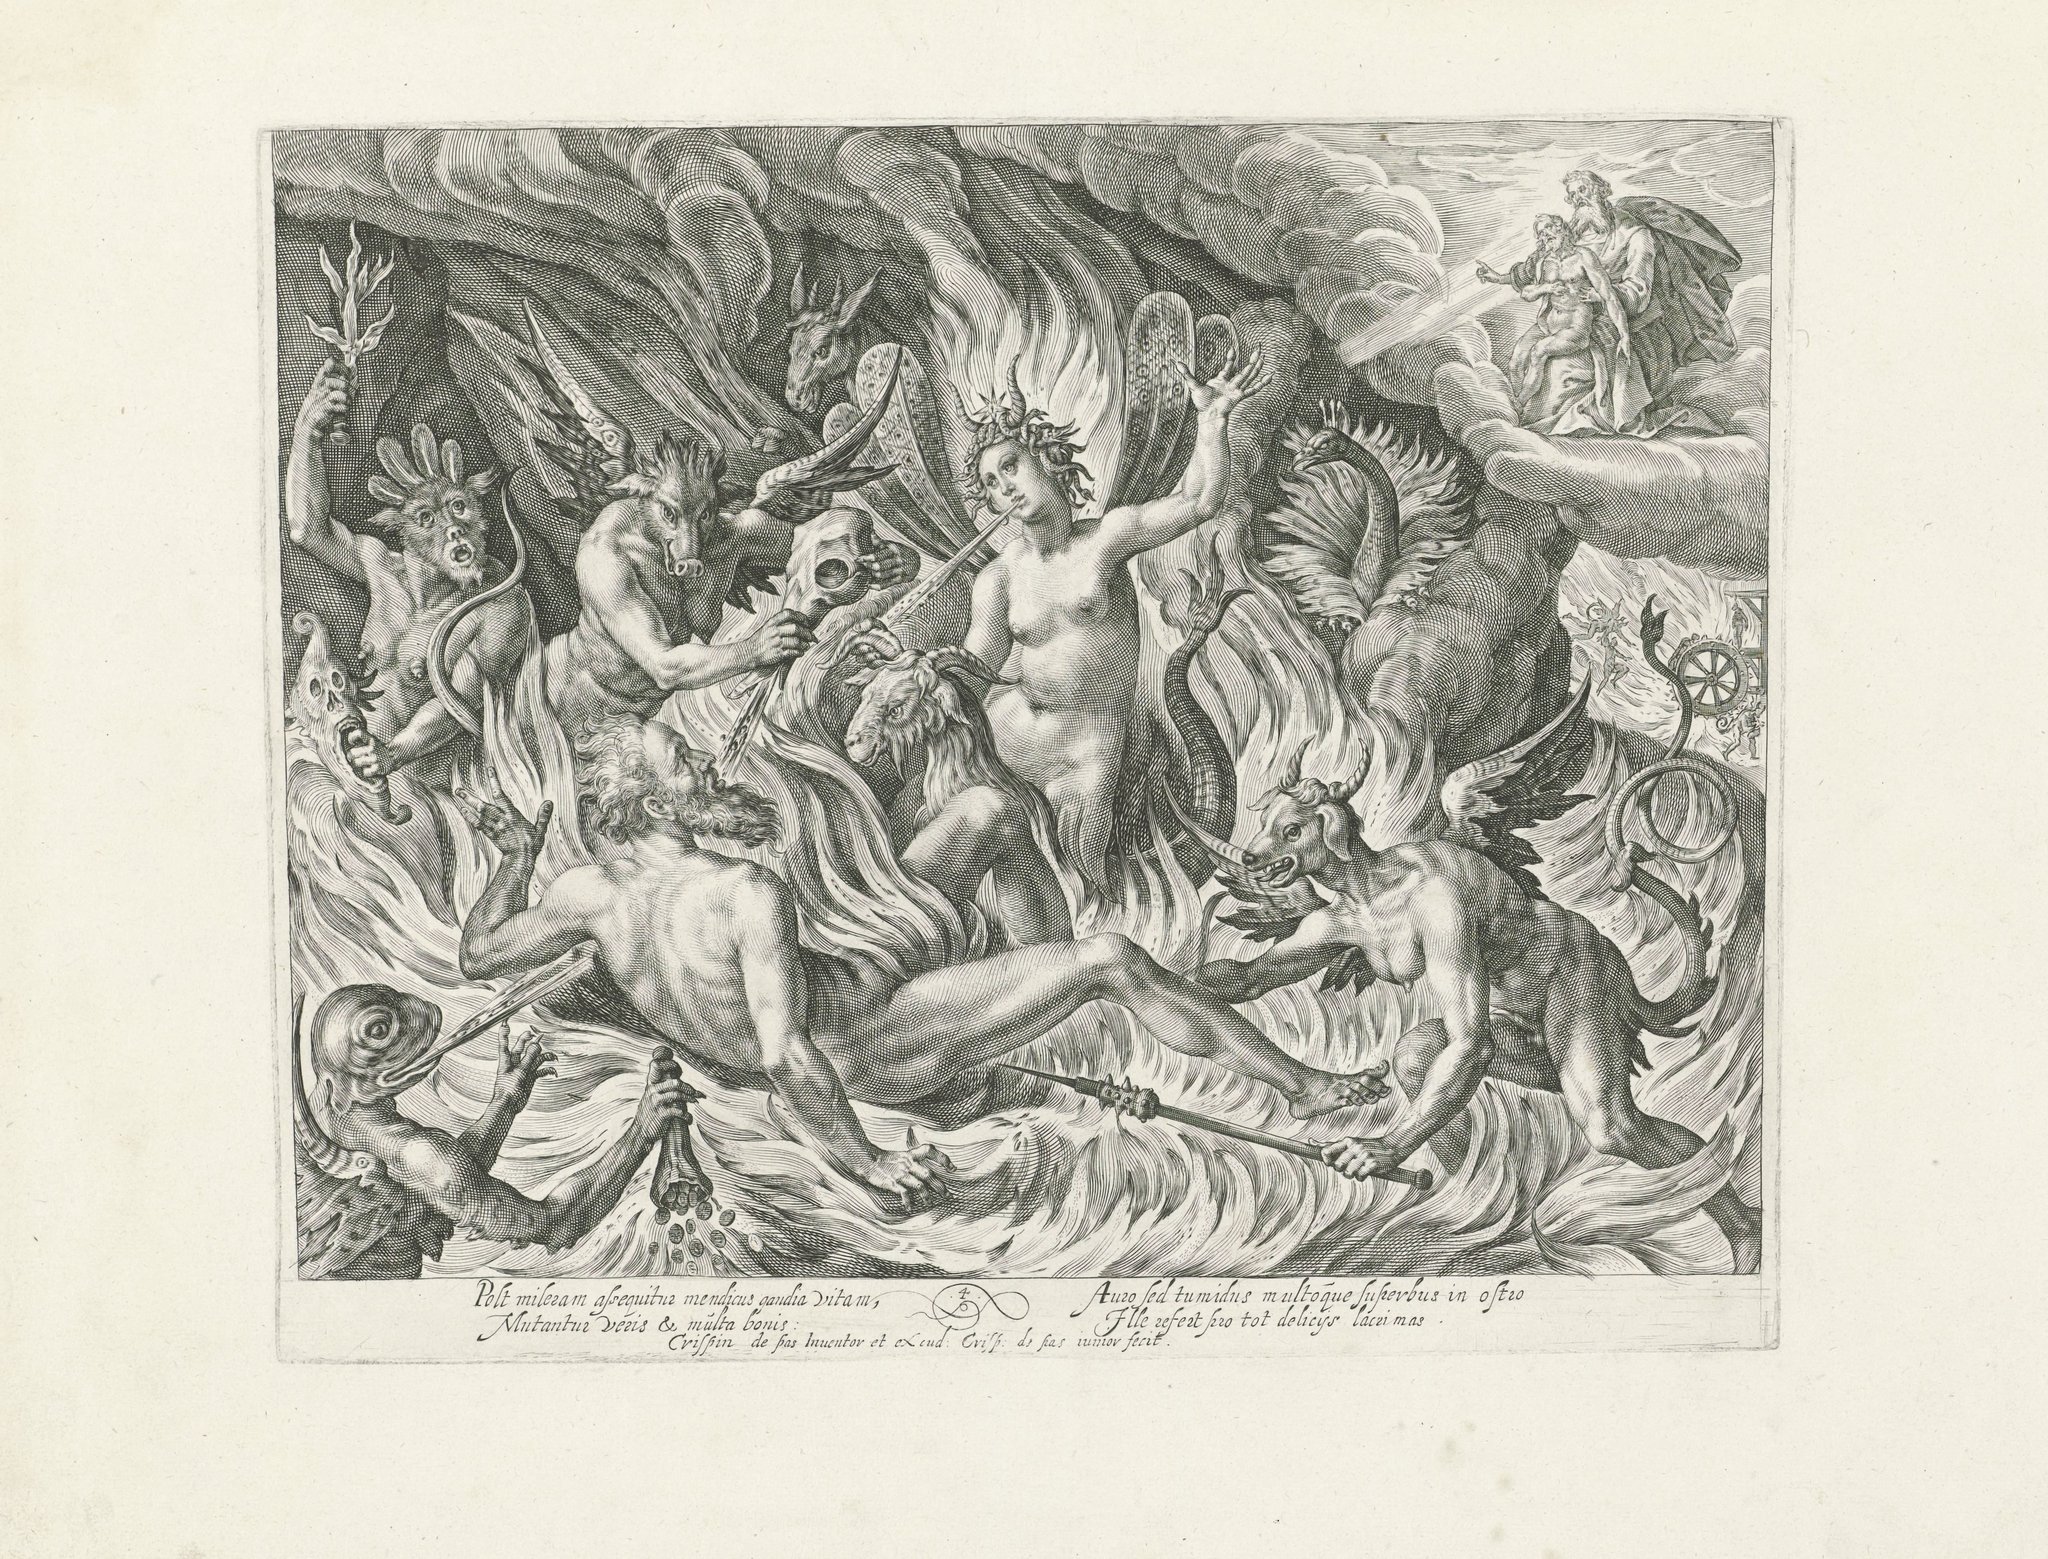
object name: print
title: Lazarus in de hemel en de rijke man in de hel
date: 1604-1637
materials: paper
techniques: engraving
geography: northern netherlands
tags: in hell dives sees lazarus in paradise; usually dives pointing at his tongue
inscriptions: collector's mark: Lugt 2228, collector's mark: Lugt 2760, number: ‘81’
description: De rijke man brandt in de hel en wordt door duivels bedreigd. Hij ziet Lazarus in de hemel op de schoot van Abraham. Prent uit een serie van vier met de gelijkenis van de rijke man en de arme Lazarus.